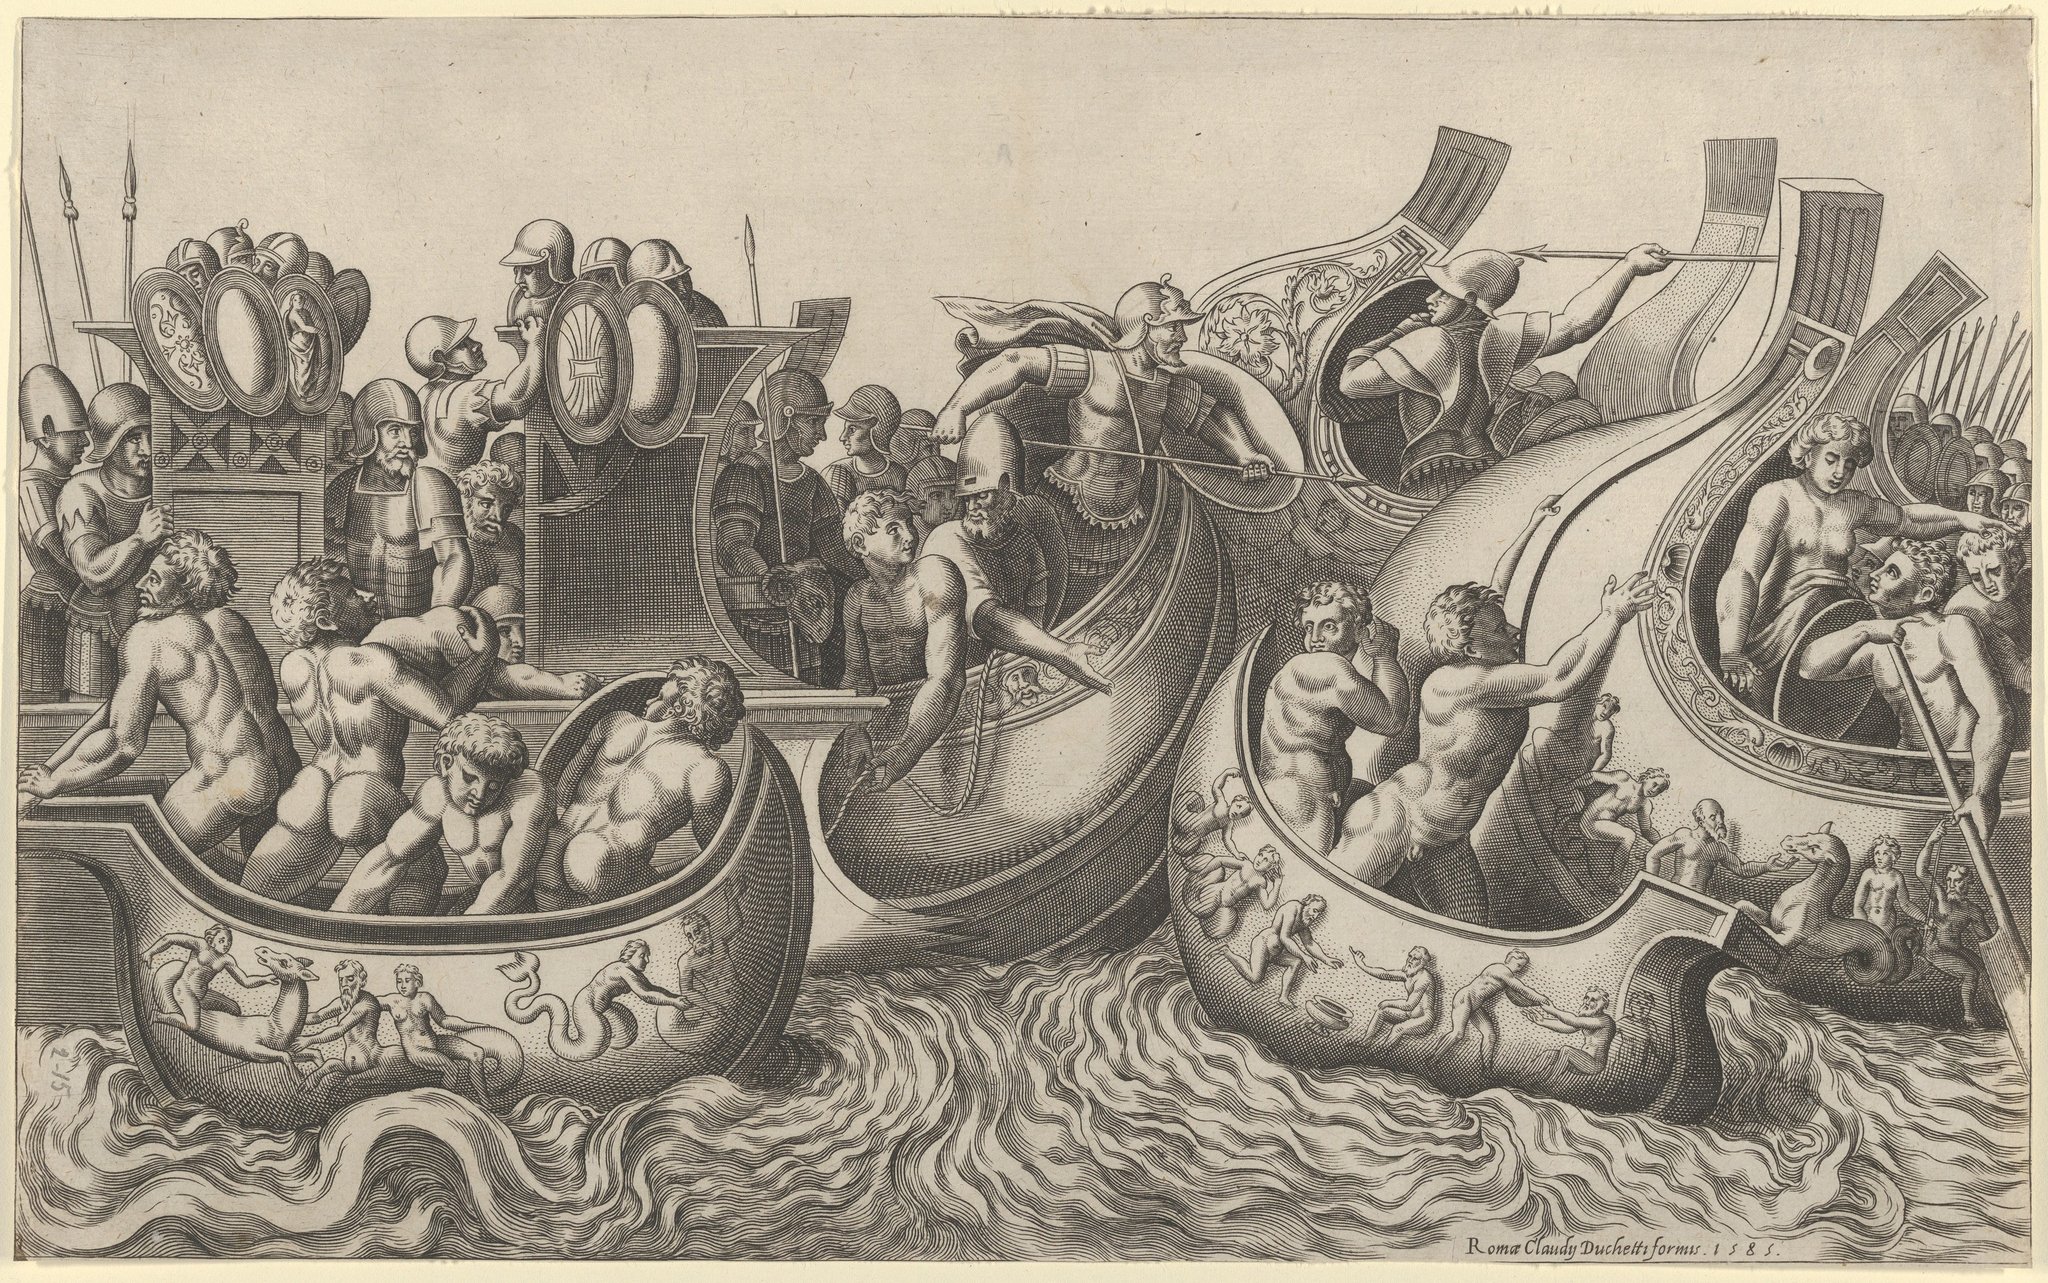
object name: print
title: Naval Battle, from "Speculum Romanae Magnificentiae"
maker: master of the die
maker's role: artist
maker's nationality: italian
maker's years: 1525-1560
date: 1501-1600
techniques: engraving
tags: battles,soldiers,male nudes,boats